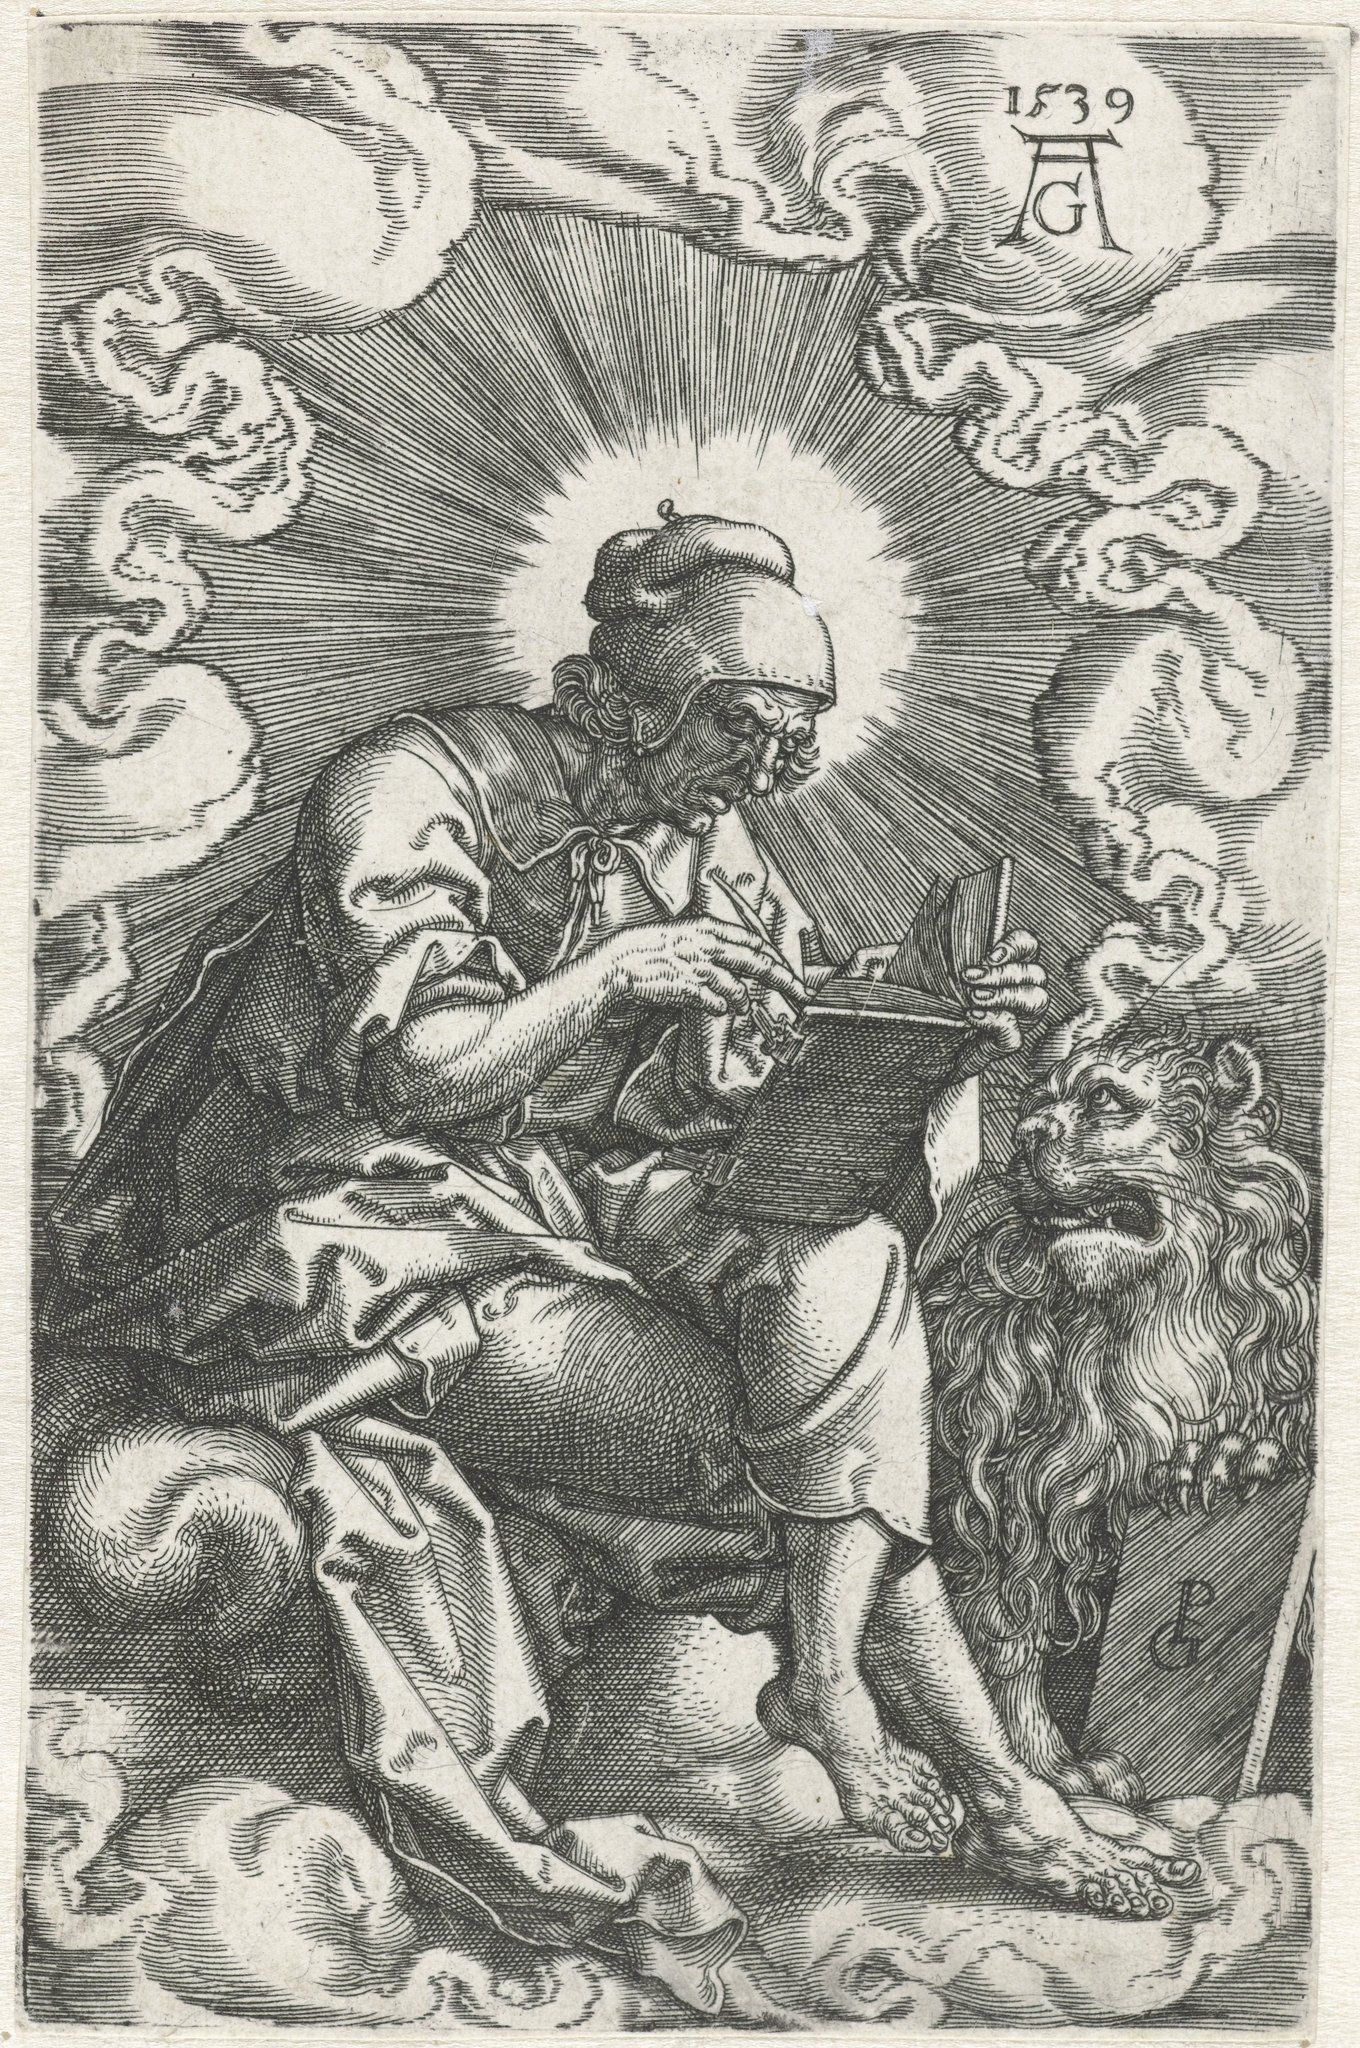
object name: print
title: Marcus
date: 1539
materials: paper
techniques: engraving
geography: germany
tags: st. mark the evangelist writing the gospel, usually a (winged) lion present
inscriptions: date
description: De evangelist Marcus zittend op een wolk en schrijvend in zijn boek, rechts van hem de leeuw.